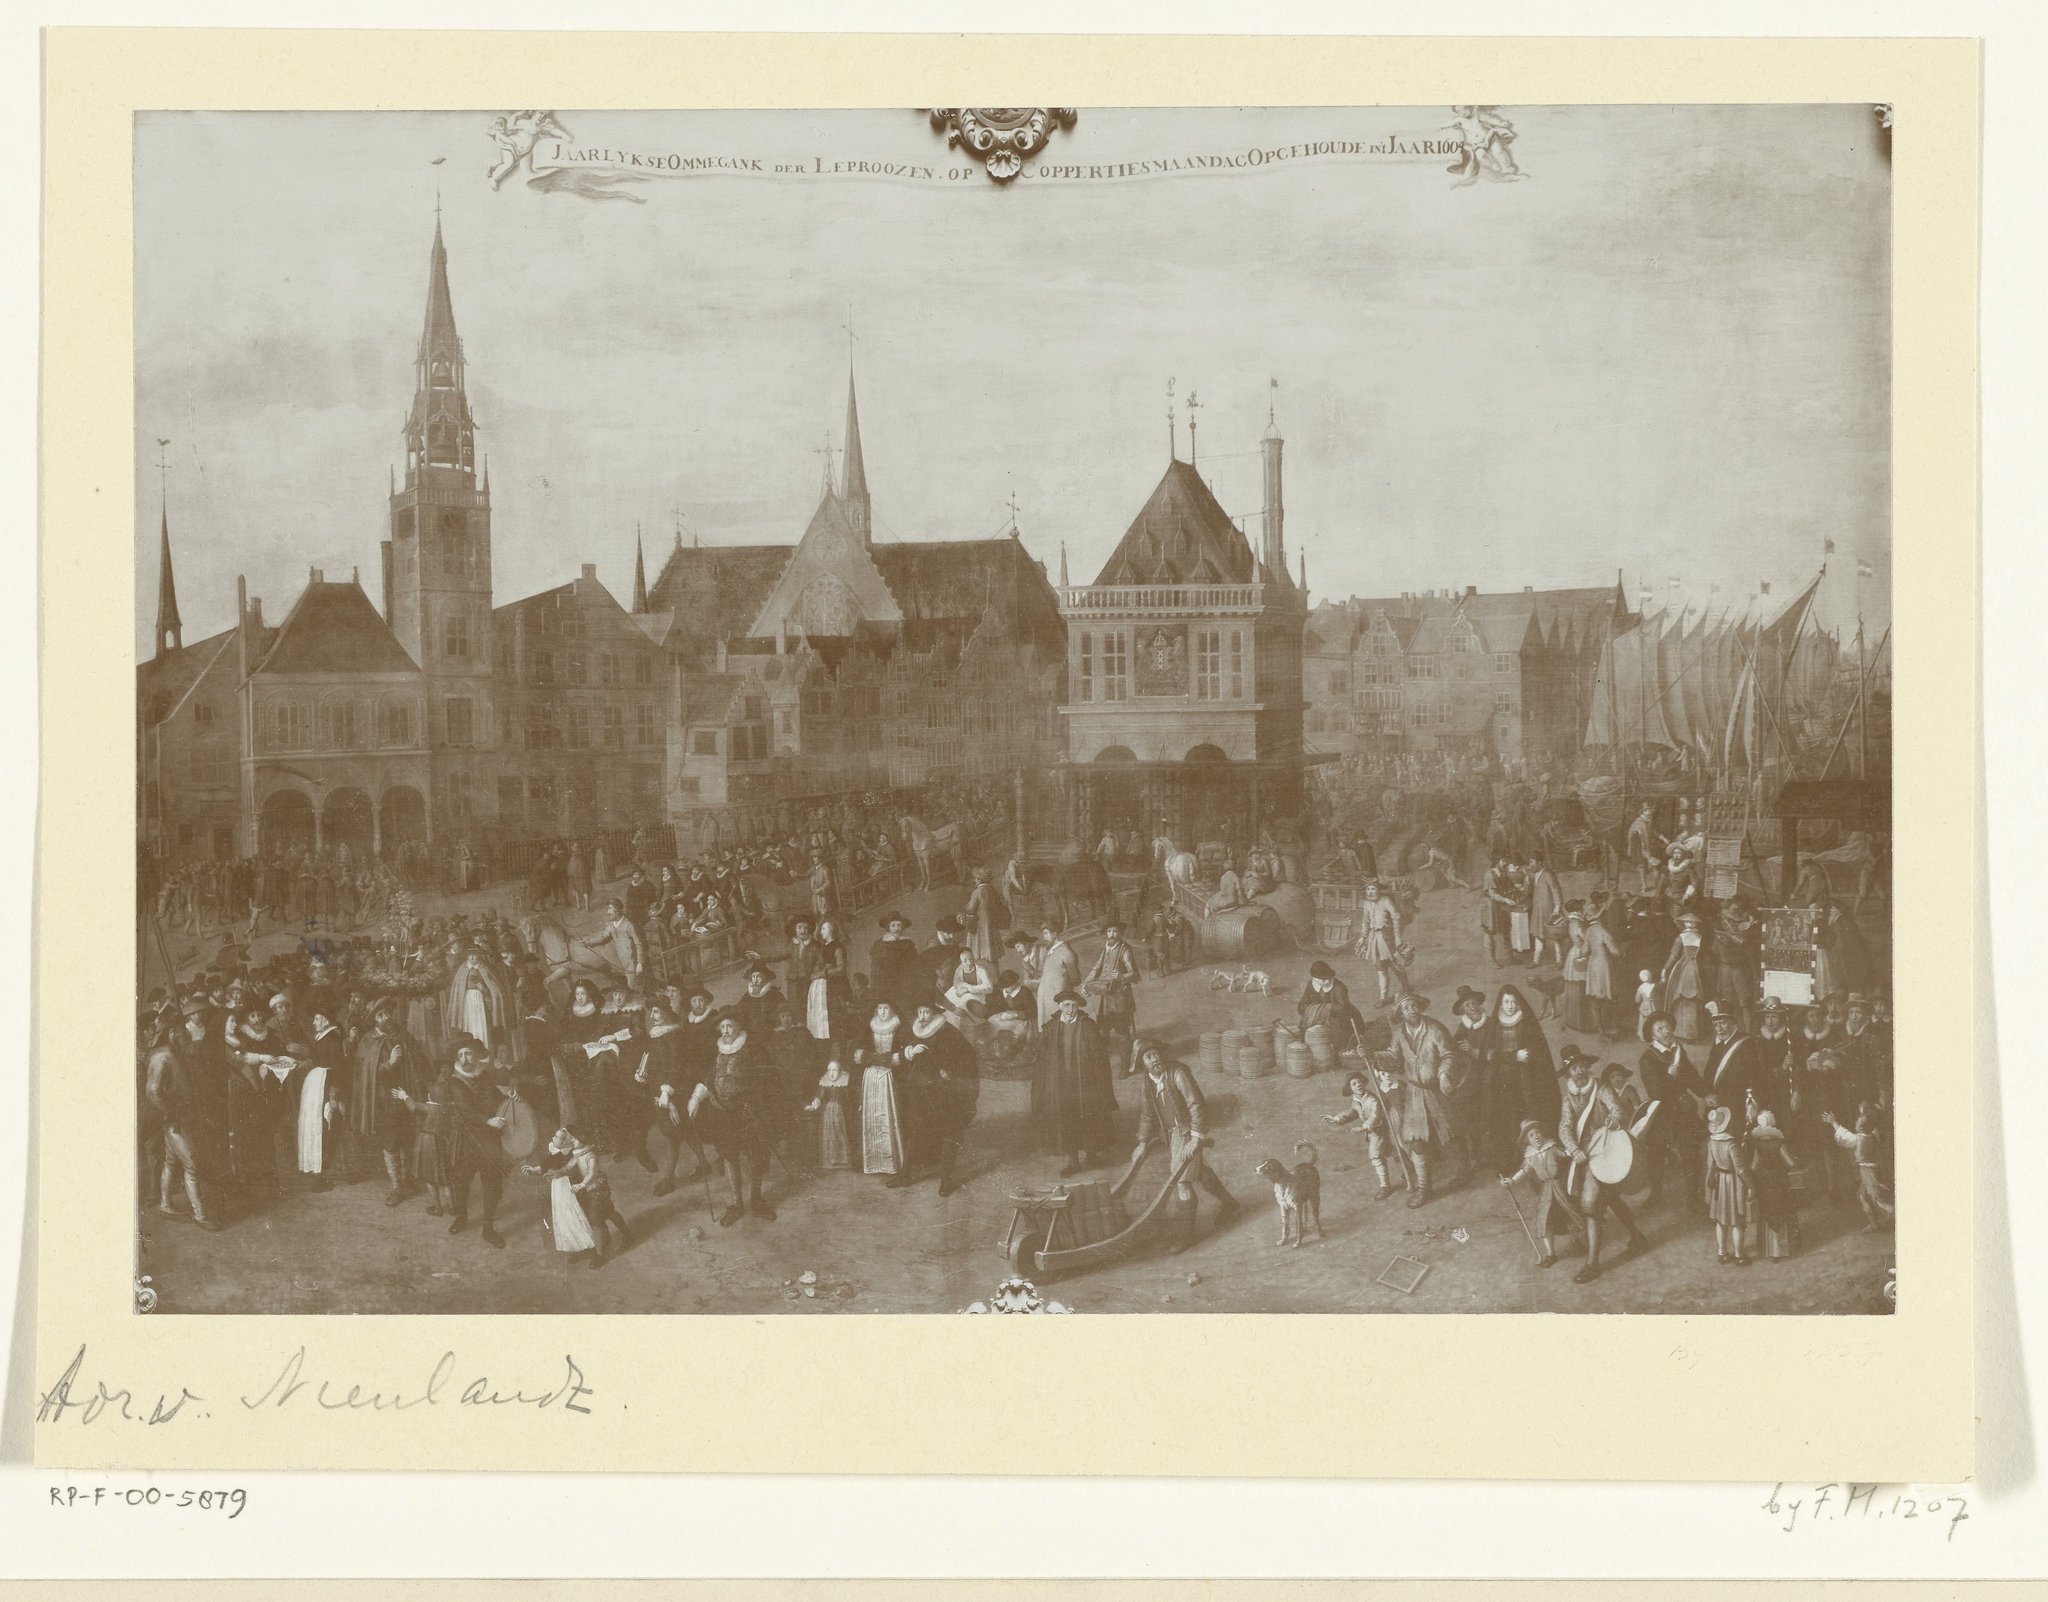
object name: photograph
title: Jaarlijkse omgang der leprozen op koppertjesmaandag in Amsterdam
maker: Anonymous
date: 1880-1907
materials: cardboard, photographic support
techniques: albumen print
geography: netherlands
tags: 'blue monday', leper's procession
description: Jaarlijkse omgang der leprozen op koppersmaandag in Amsterdam, 1604 (?). Optocht en feestelijkheden van de gilden op de Dam waarbij de leprozen de stad in mogen en waarbij geld werd ingezameld voor de leprozen. In 1604 werd Koppermaandag voor het laatst in Amsterdam gevierd. Foto van het schilderij in de collectie van het Amsterdams Historisch Museum.